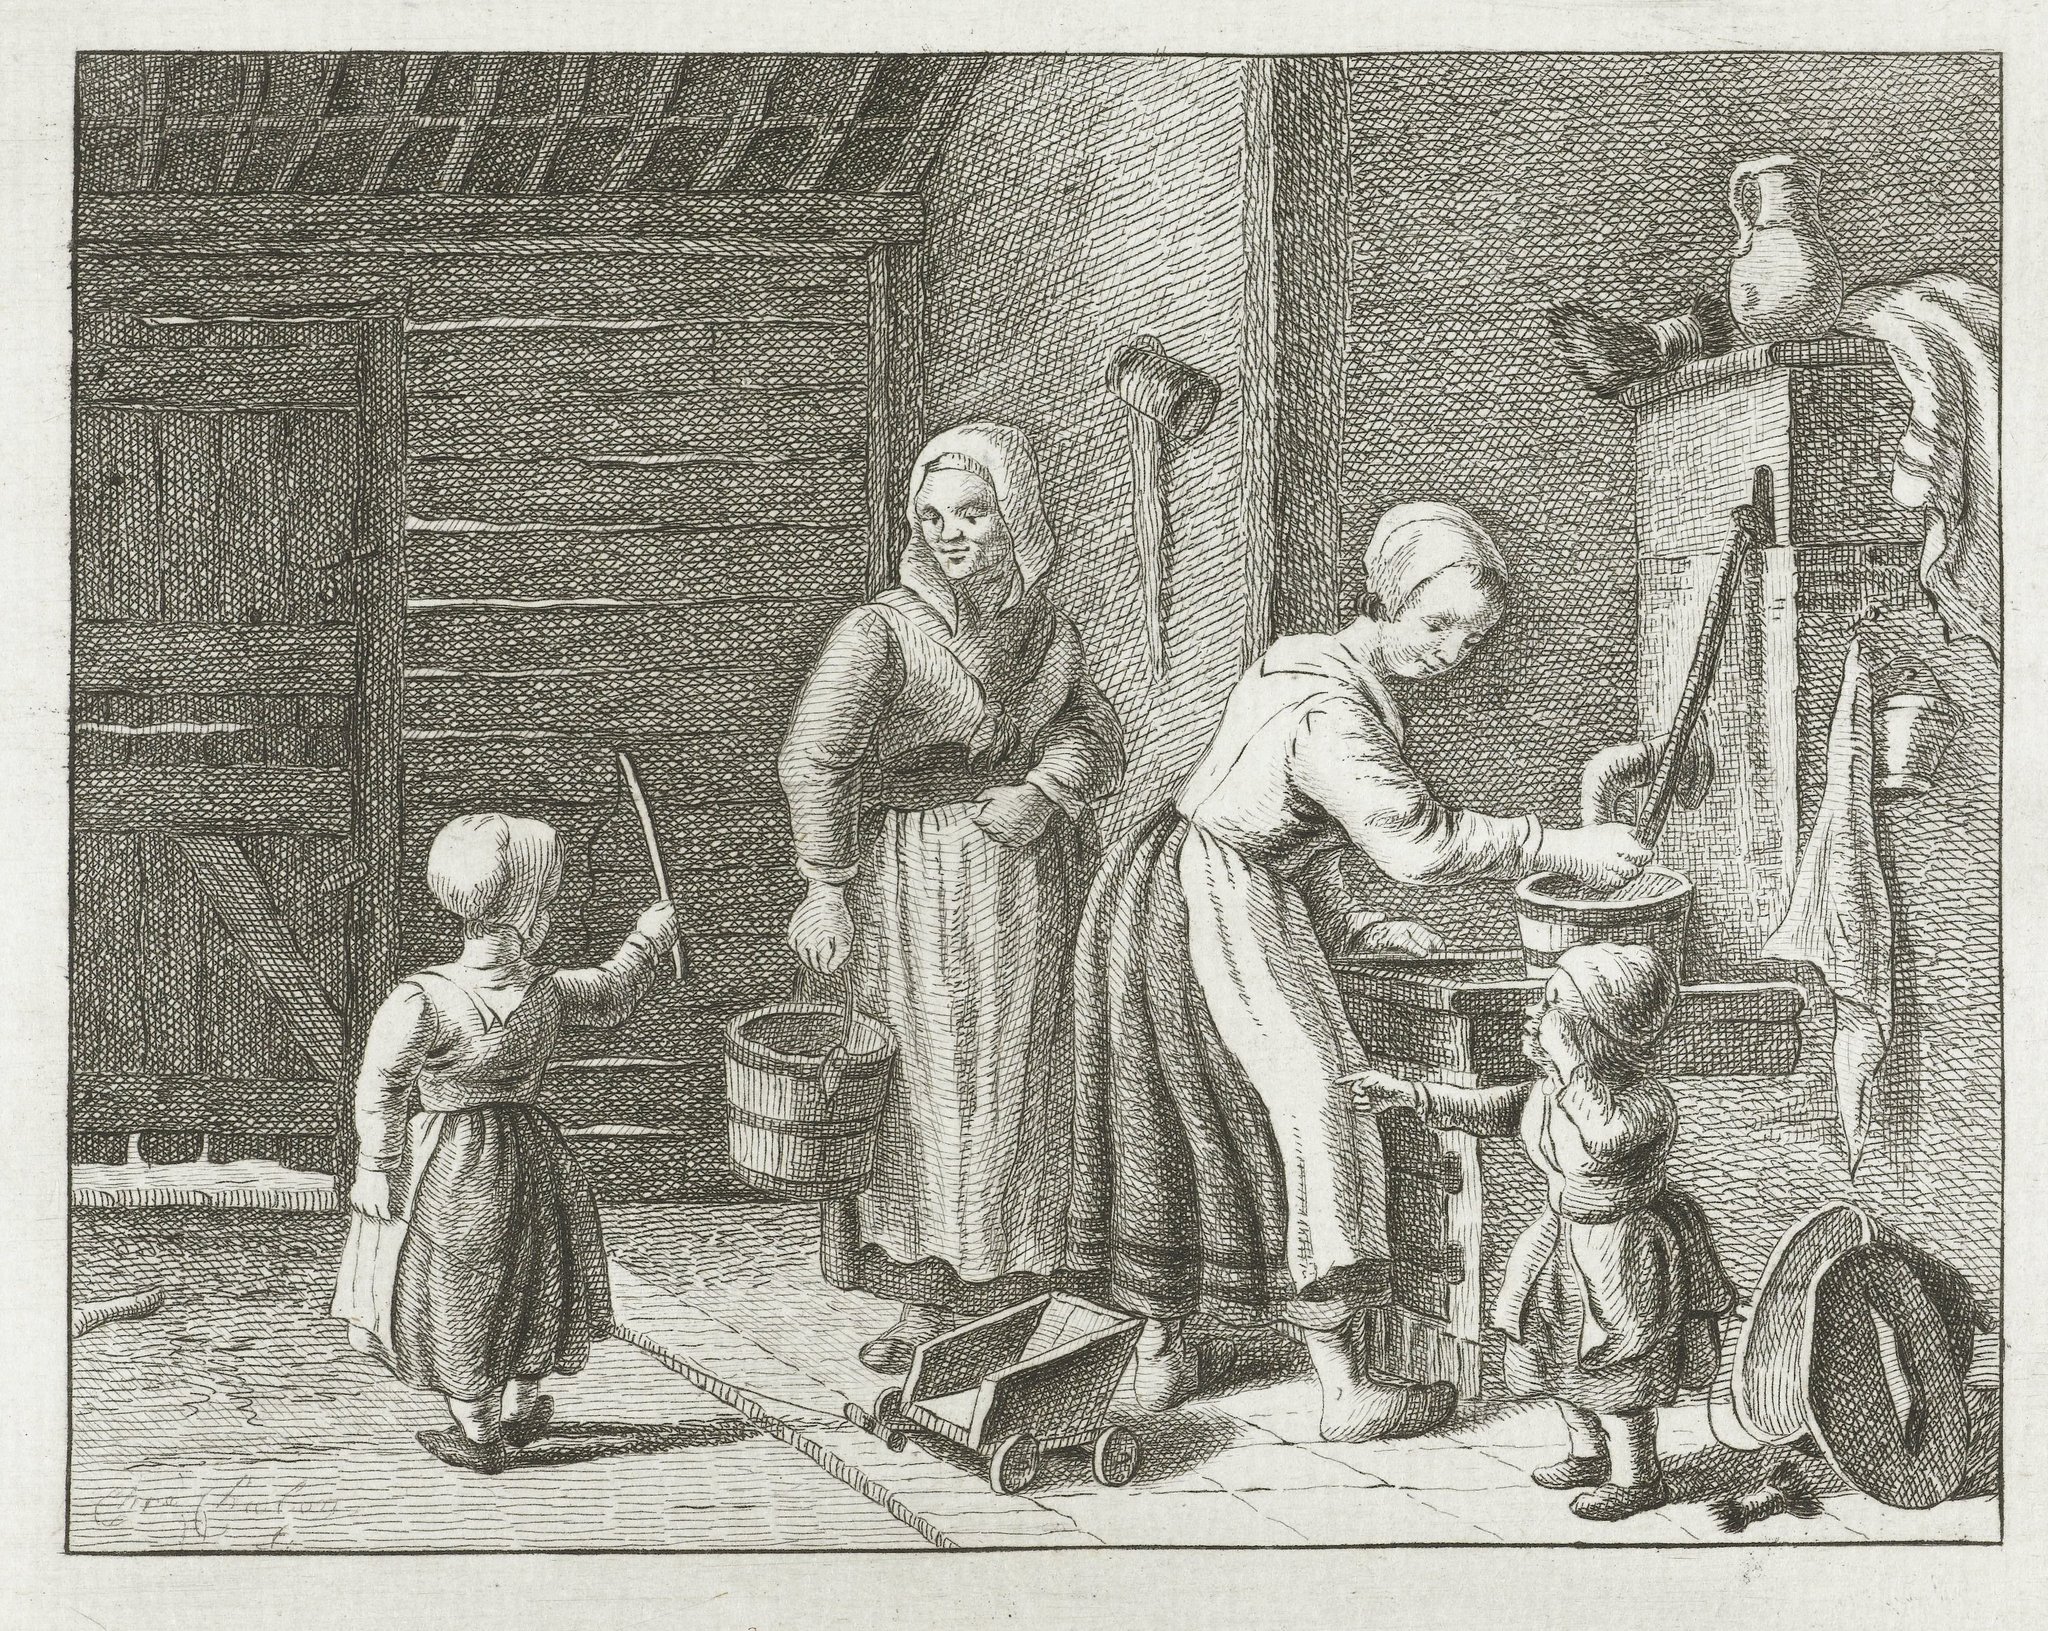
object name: print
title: Vrouwen en kinderen in interieur bij waterpomp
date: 1779-1796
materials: paper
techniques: etching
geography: leiden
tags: farmers - aa - female farmer, farmer's wife, weeping, (playing with) wheeled vehicles, pump, mother and daughter(s) (family group) (with number of daughters)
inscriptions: collector's mark: Lugt 2233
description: Twee vrouwen pompen water uit een pomp. Hun kinderen zijn aan het spelen. Het oudste meisje speelt met een rolwagen en een zweepje. De jongste huilt omdat haar speelgoed door de oudste is afgepakt.